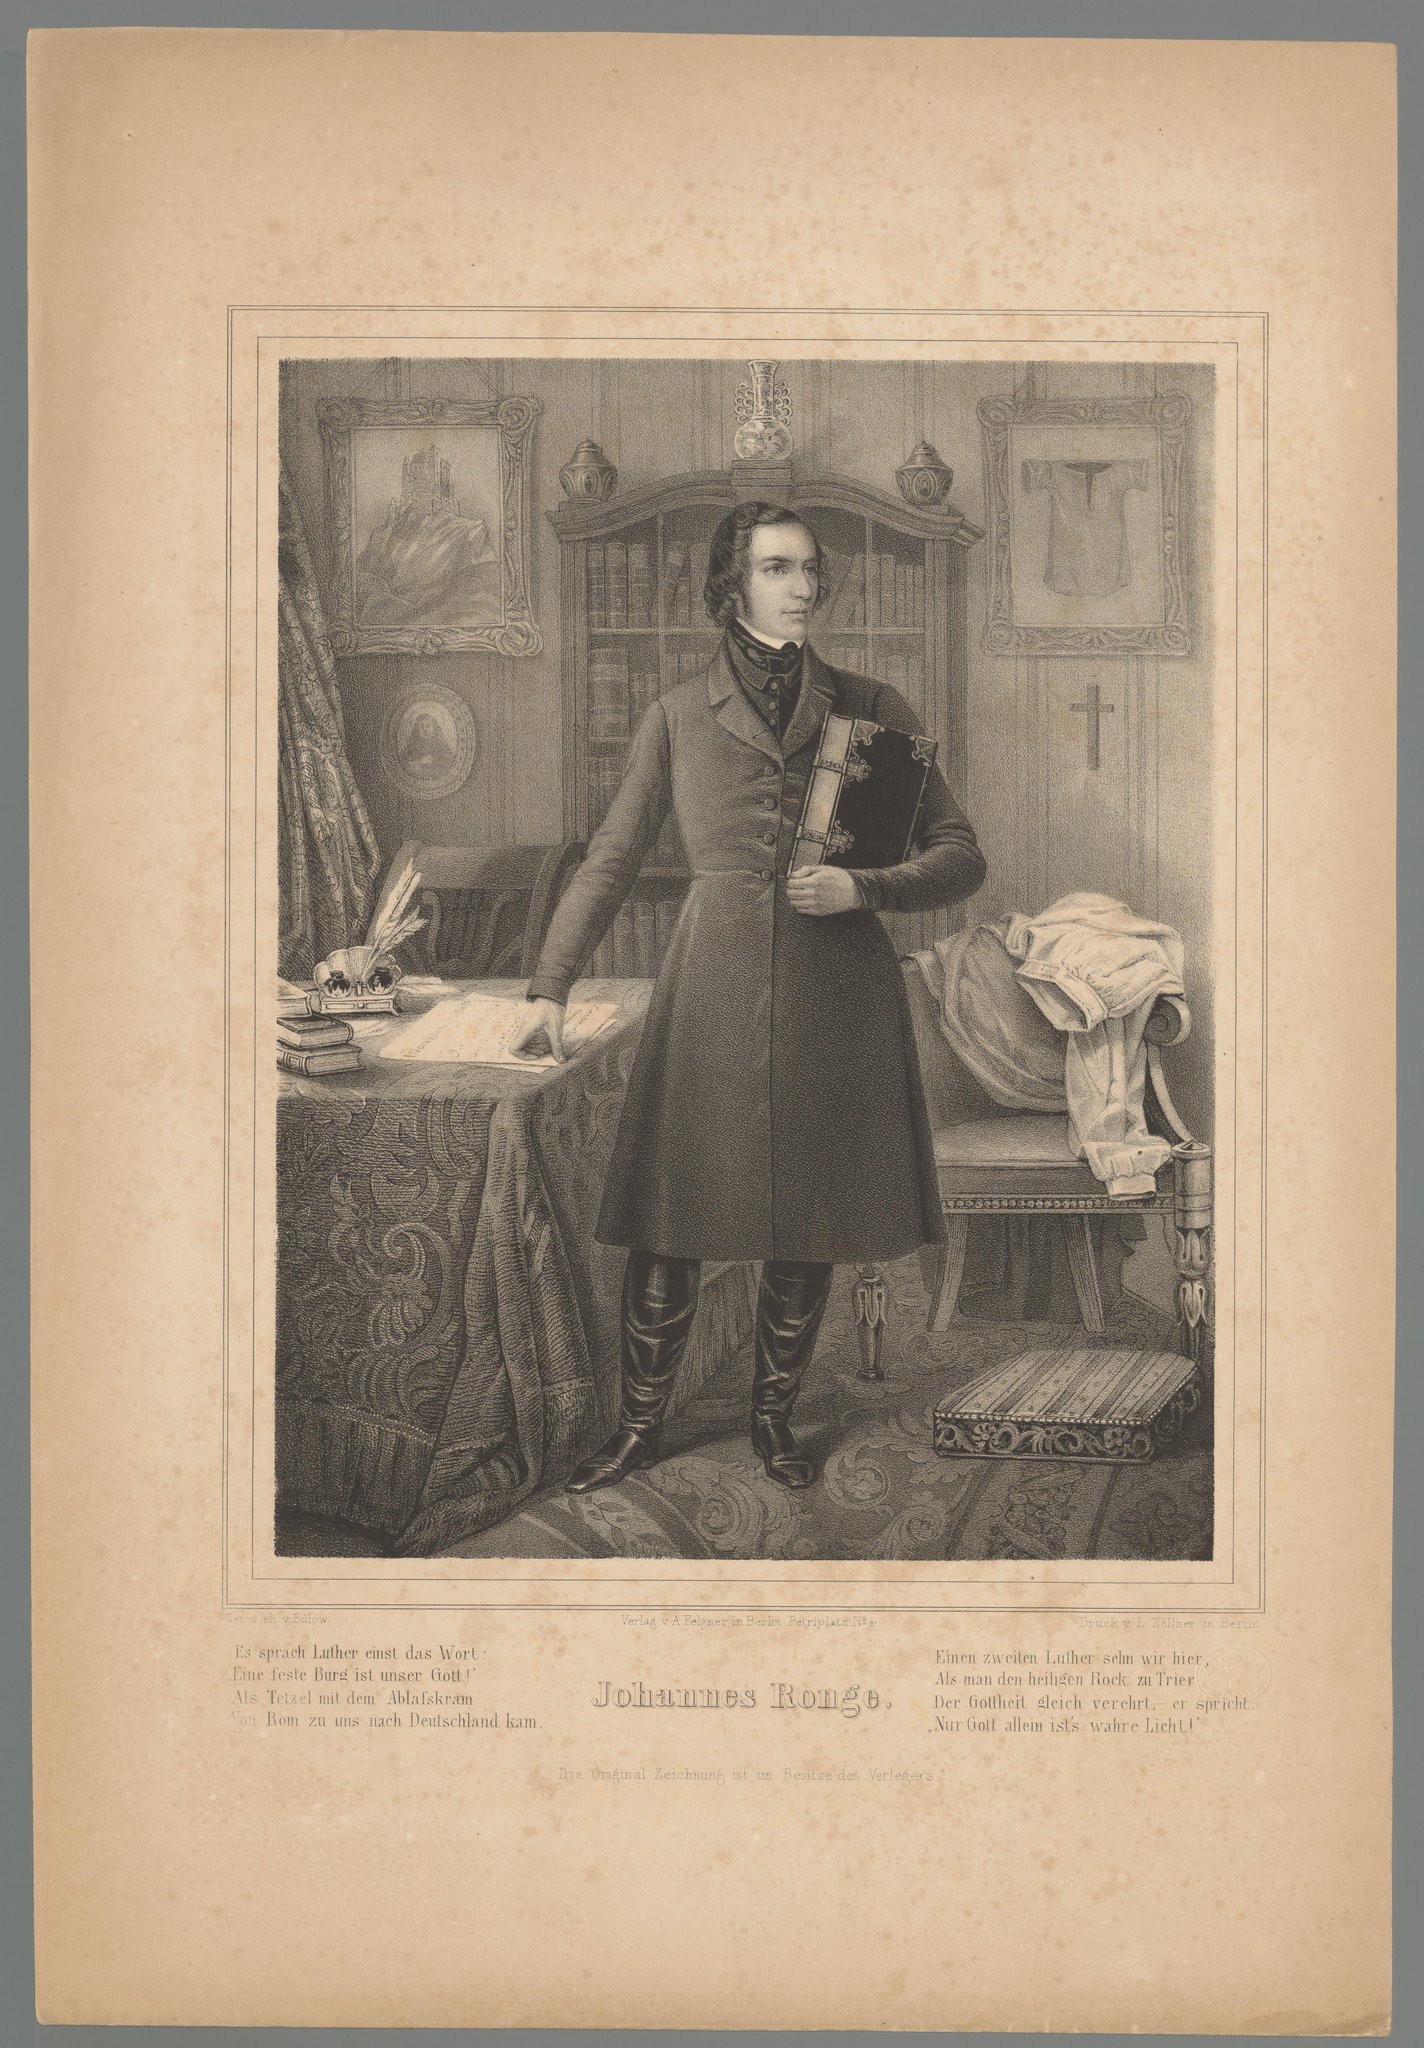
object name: print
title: Johannes Ronge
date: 1830-1848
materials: paper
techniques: lithograph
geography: berlin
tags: vienna, adult man, historical persons, study; 'studiolo'; library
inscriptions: check stamp: ‘Kunstverlag von I.A. Felgner’, collector's mark: Lugt 2228